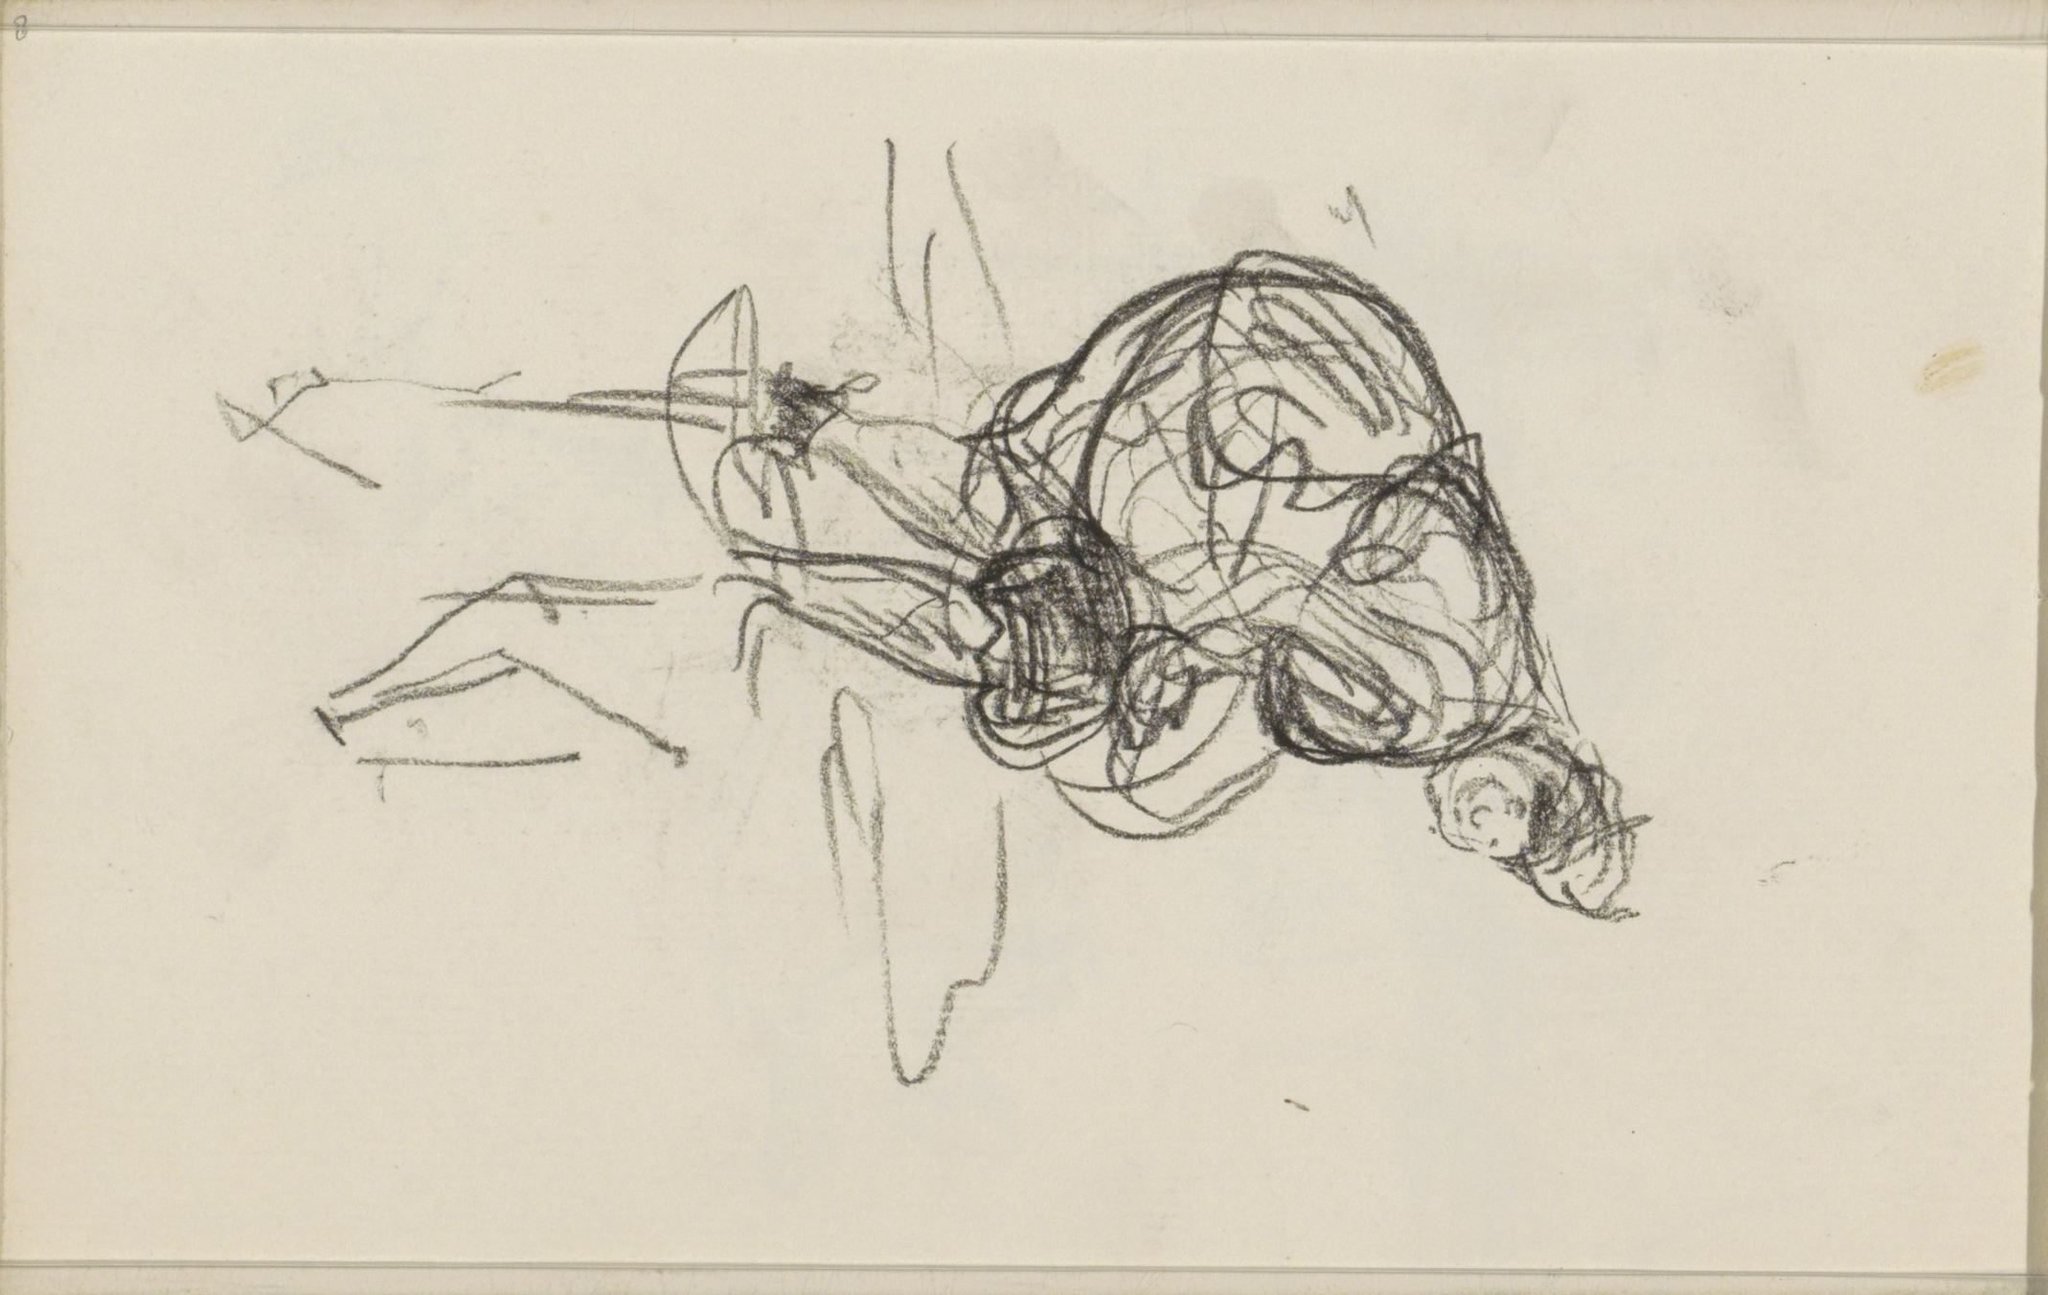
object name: sketchbook leaf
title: Pootje badende vrouw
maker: marius bauer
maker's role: draughtsman, print maker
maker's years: 1867-1932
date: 1877-1885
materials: chalk, paper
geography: scheveningen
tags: adult woman, bending figure, wading, paddling, sea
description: De vrouw heeft haar rok opgestroopt en buigt voorover. Pagina 8 uit een schetsboek met 8 bladen.